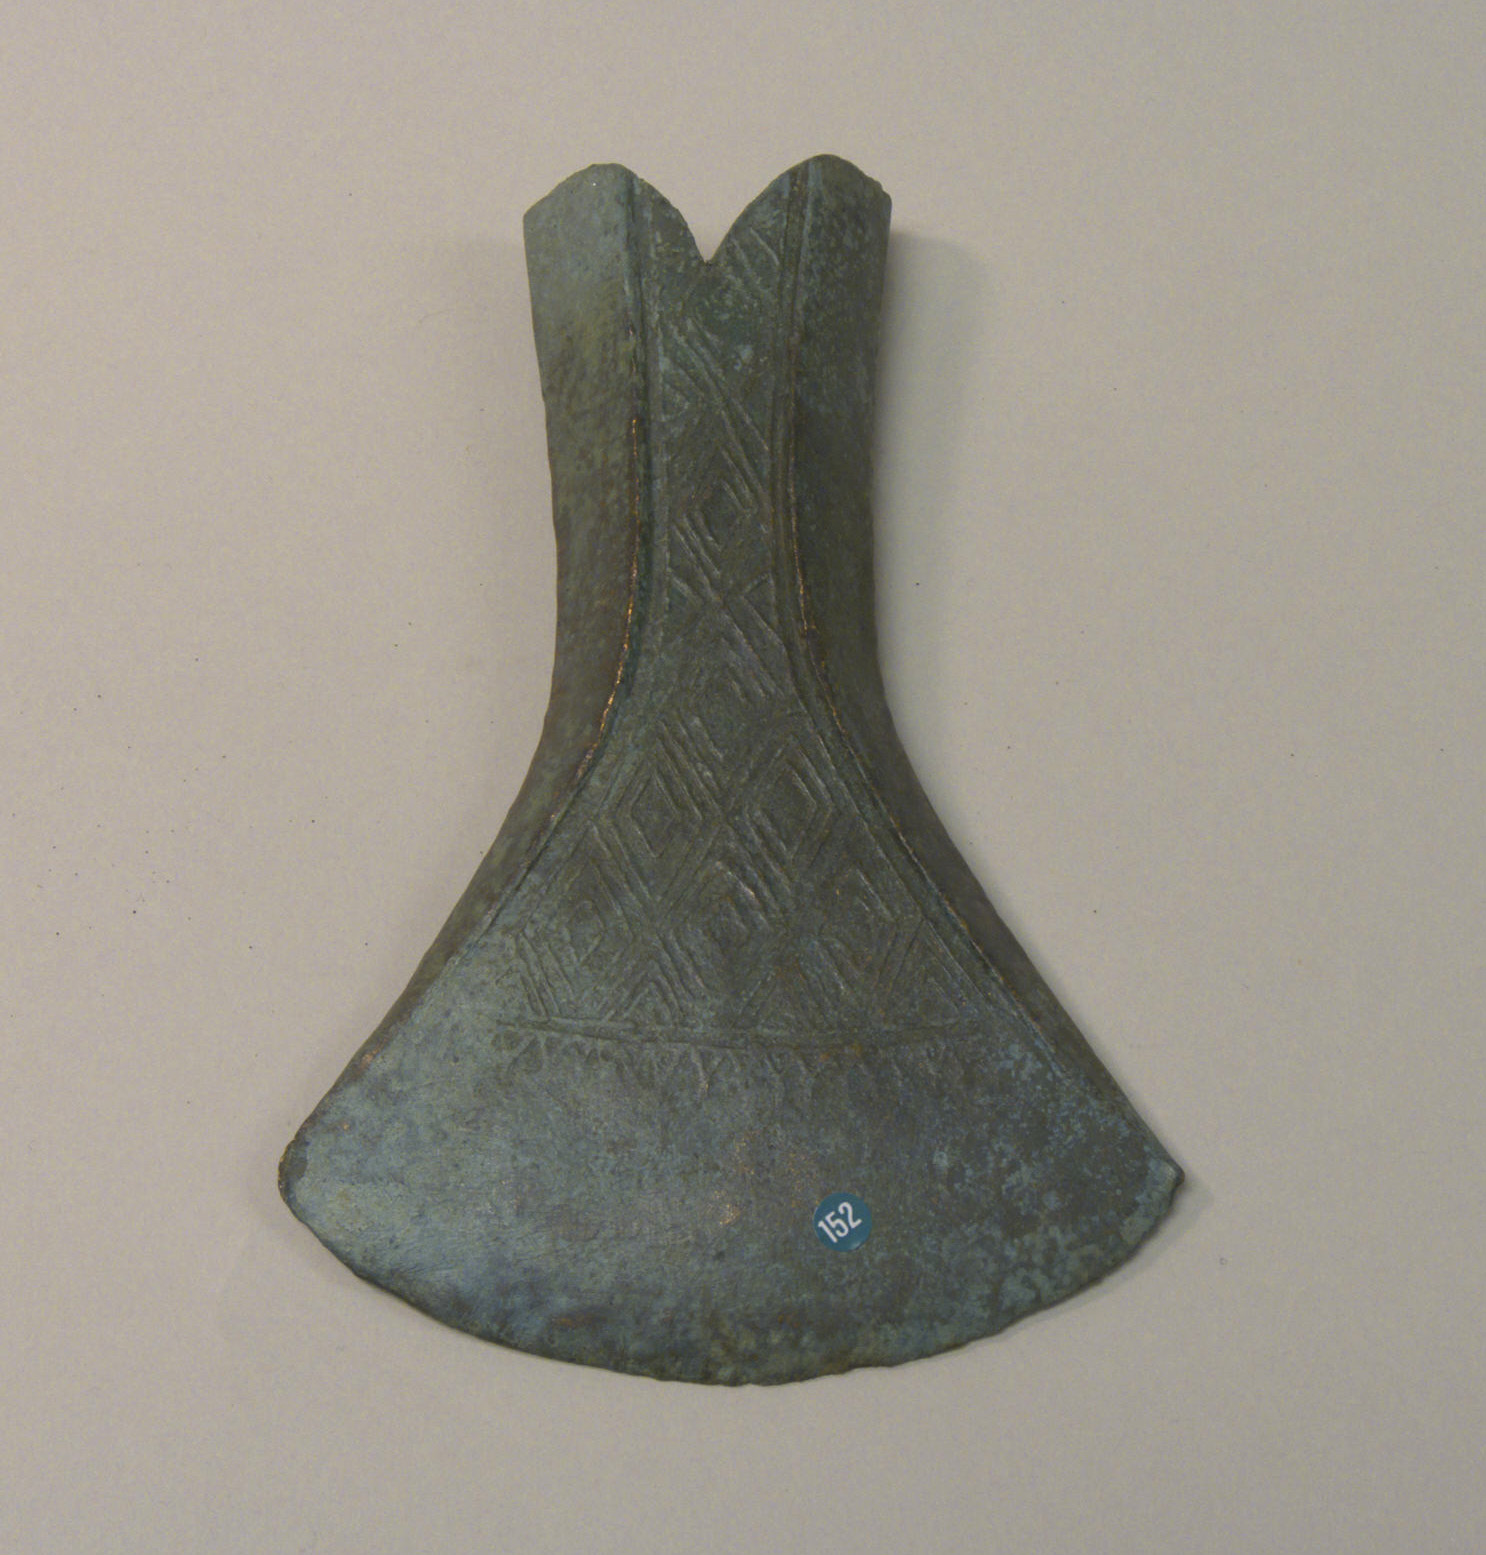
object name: hafted ax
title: Swallowtail Hafted Ax with Diamond Pattern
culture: indonesian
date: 500 BCE-300 CE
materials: bronze